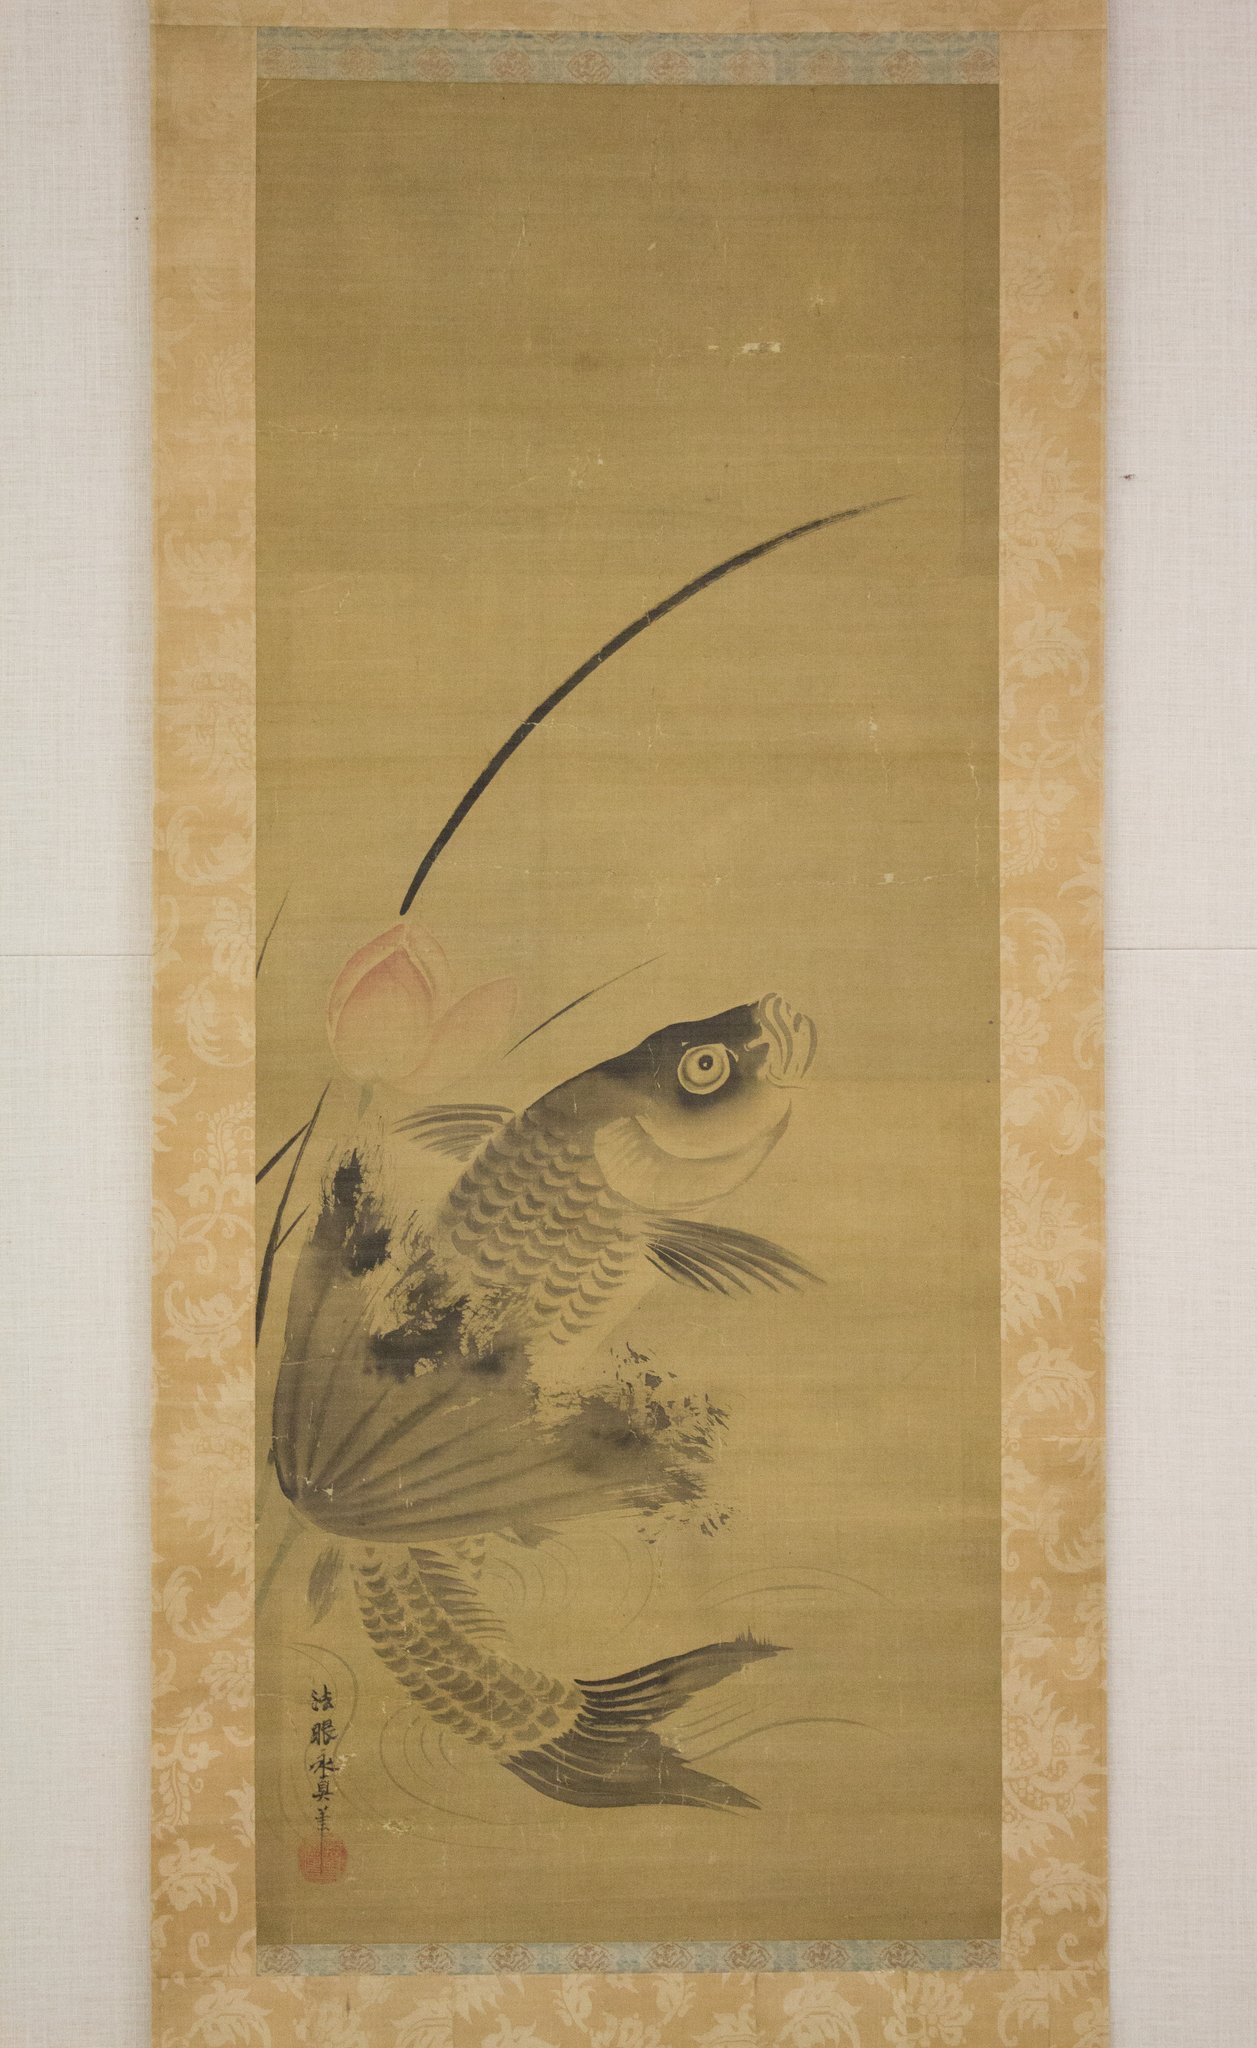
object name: hanging scroll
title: Fish and Lotus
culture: japanese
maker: kano yasunobu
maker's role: artist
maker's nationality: japanese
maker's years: 1614-1685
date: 1613-1685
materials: ink, silk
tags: fish,lotuses